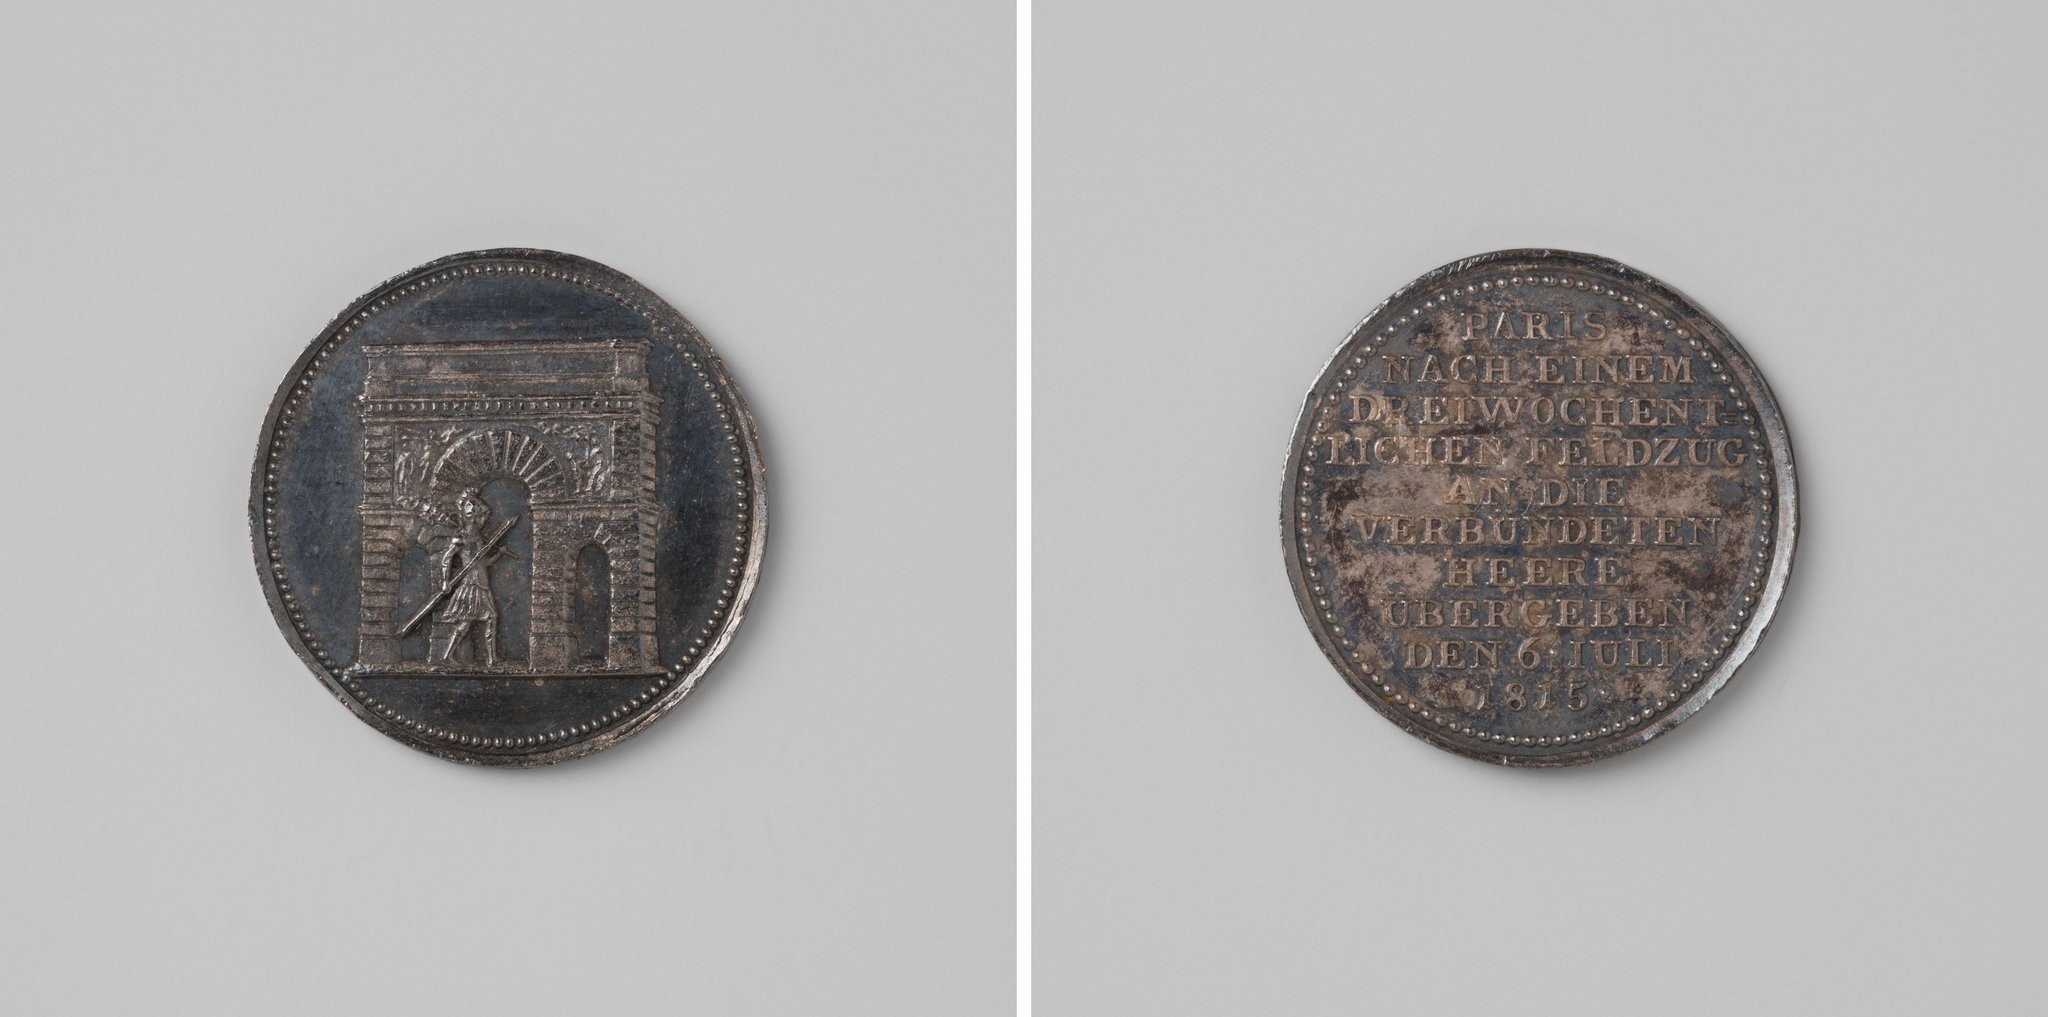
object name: history medal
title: Inname van Parijs door de geallieerden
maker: Anonymous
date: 1815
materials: silver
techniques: striking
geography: germany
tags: paris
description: Zilveren penning. Voorzijde: gehelmde soldaat met legerstandaard en speer staande voor poort. Keerzijde: opschrift